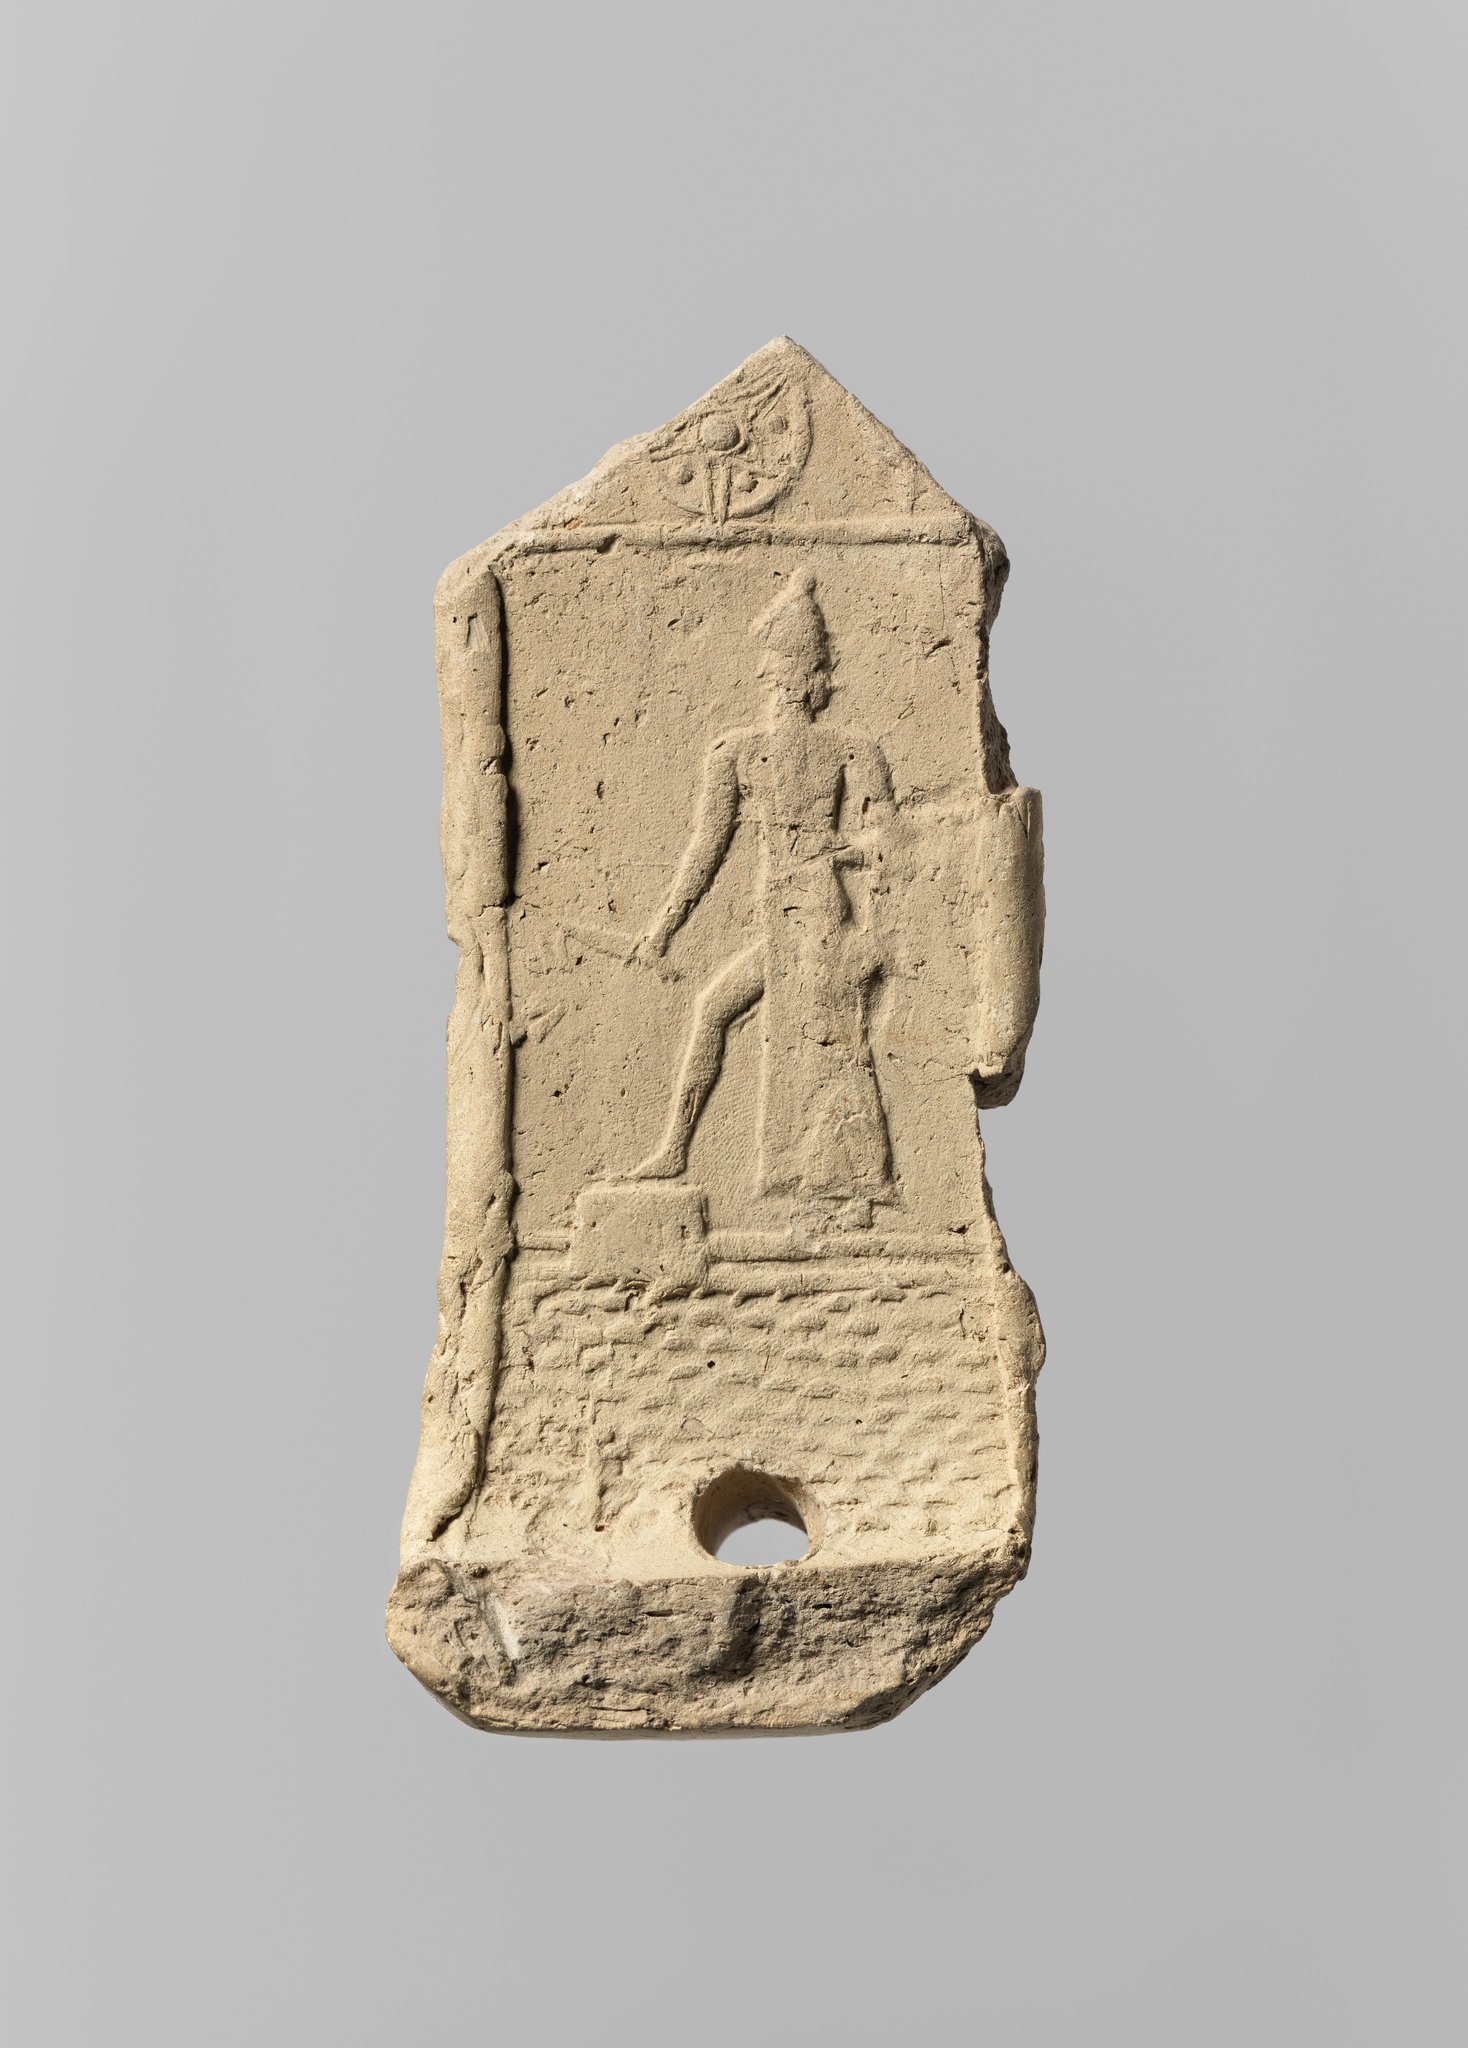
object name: model of a chariot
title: Part of a model chariot, with an impression of the sun god Shamash rising over the mountains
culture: babylonian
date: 2000-1600 BCE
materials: ceramic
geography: southern mesopotamia